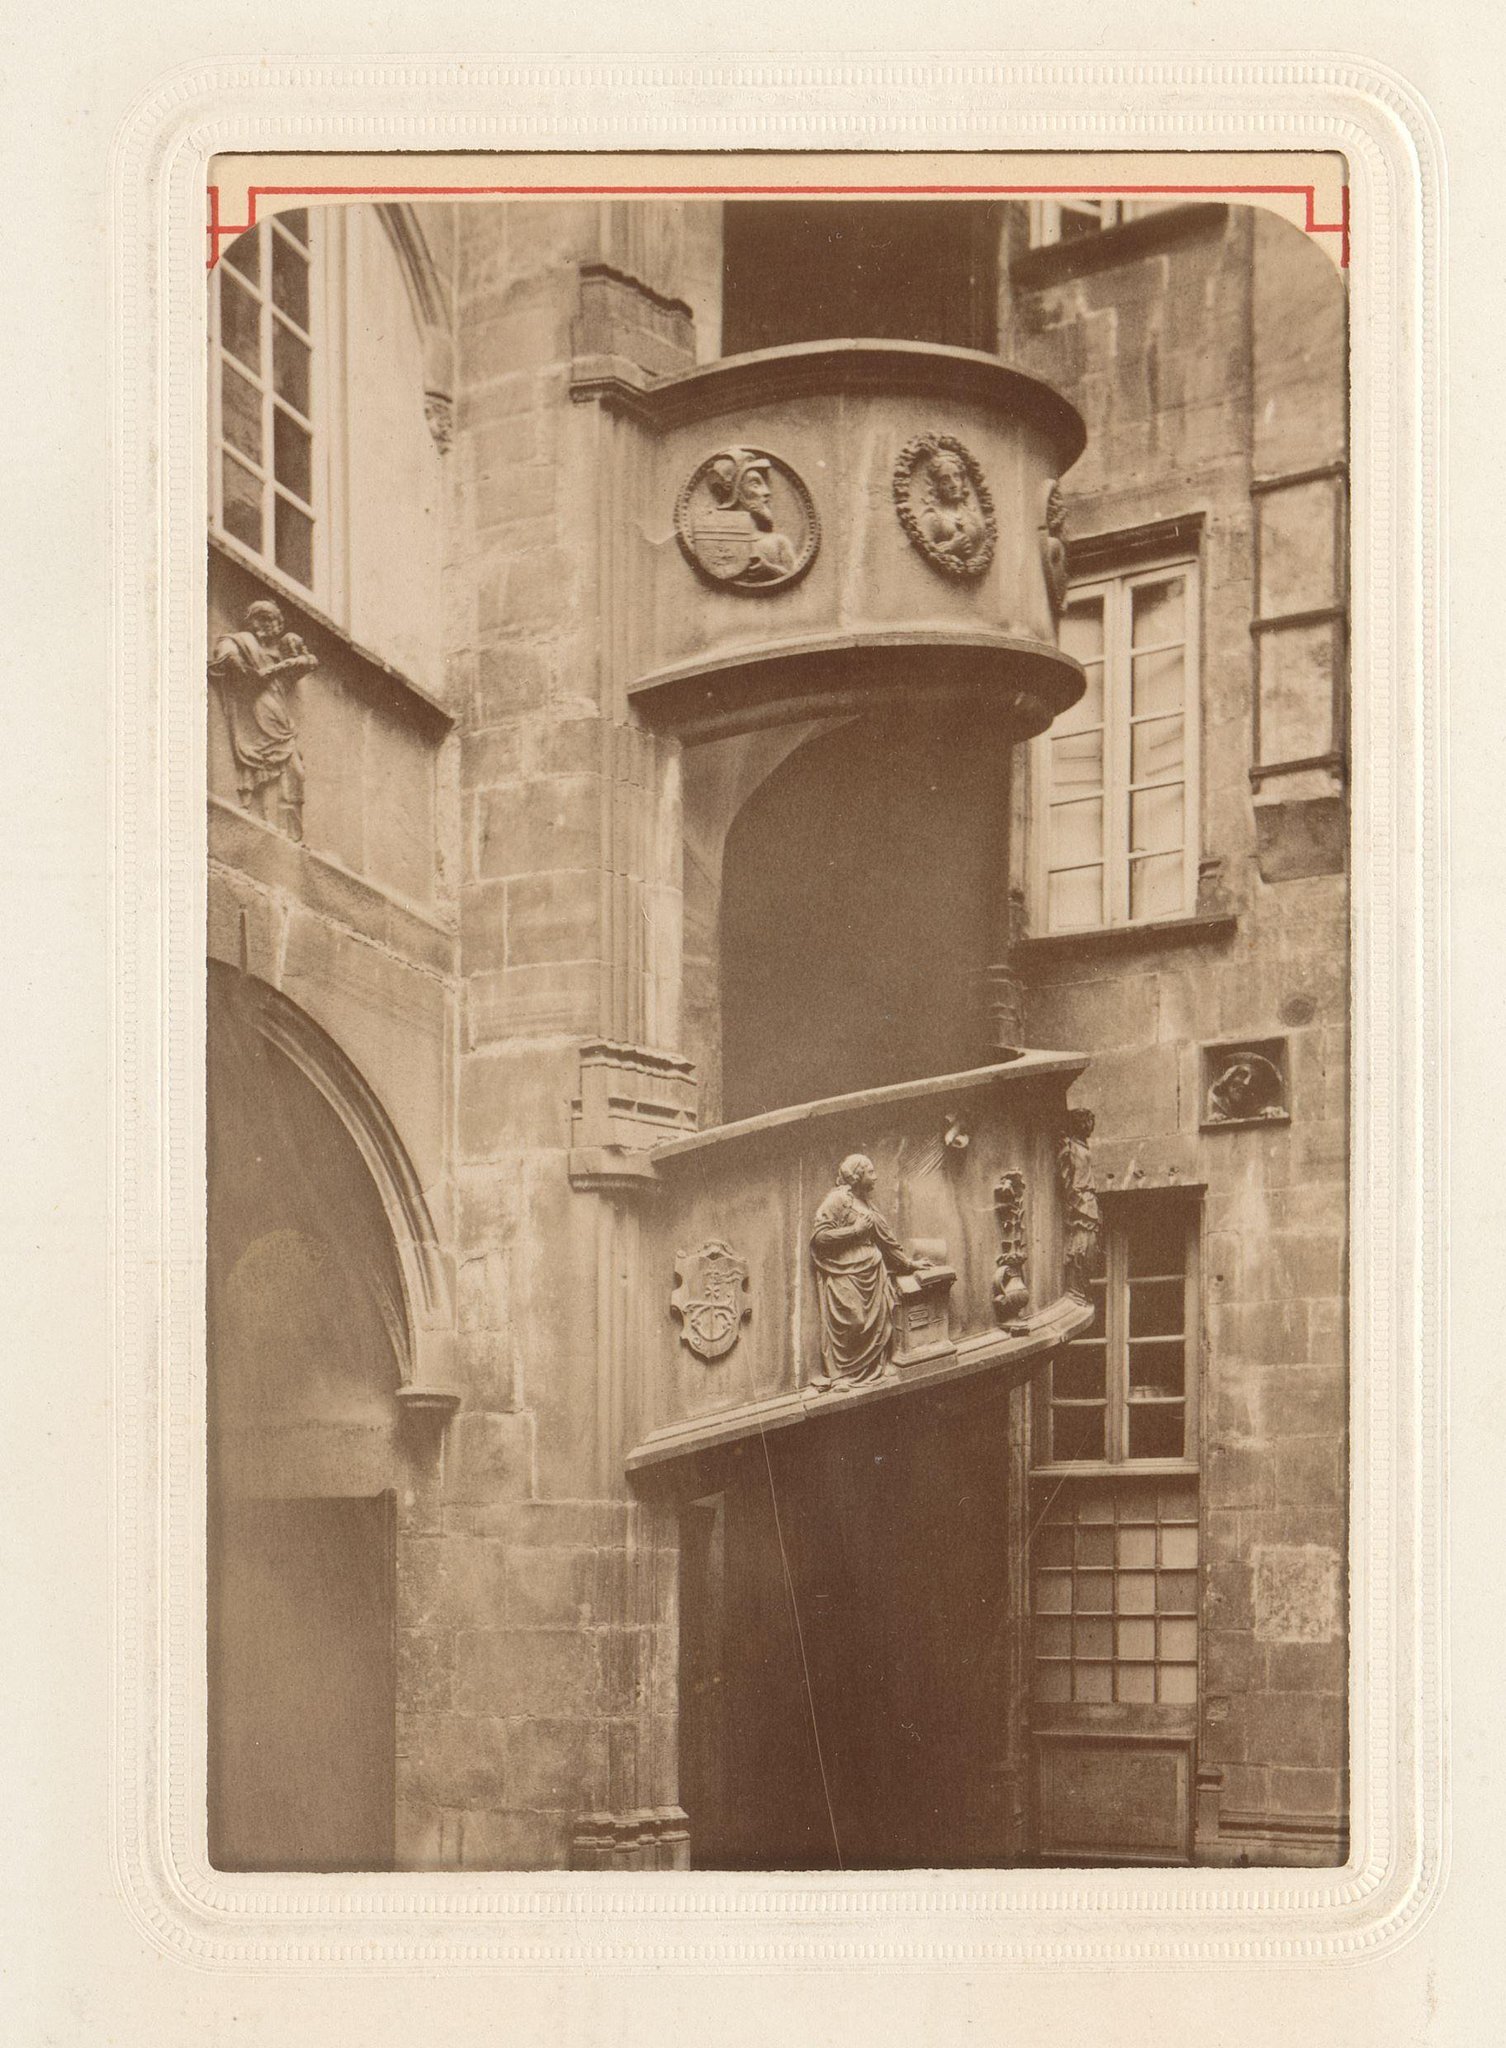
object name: album leaf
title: Gezicht op de Escalier de la Renaissance in de Tour de l'horloge, Riom, Frankrijk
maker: Anonymous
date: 1867-1900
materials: cardboard, paper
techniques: albumen print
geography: riom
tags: tower, clock tower ~ monumental adornment, staircase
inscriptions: inscription: ‘RIOM’